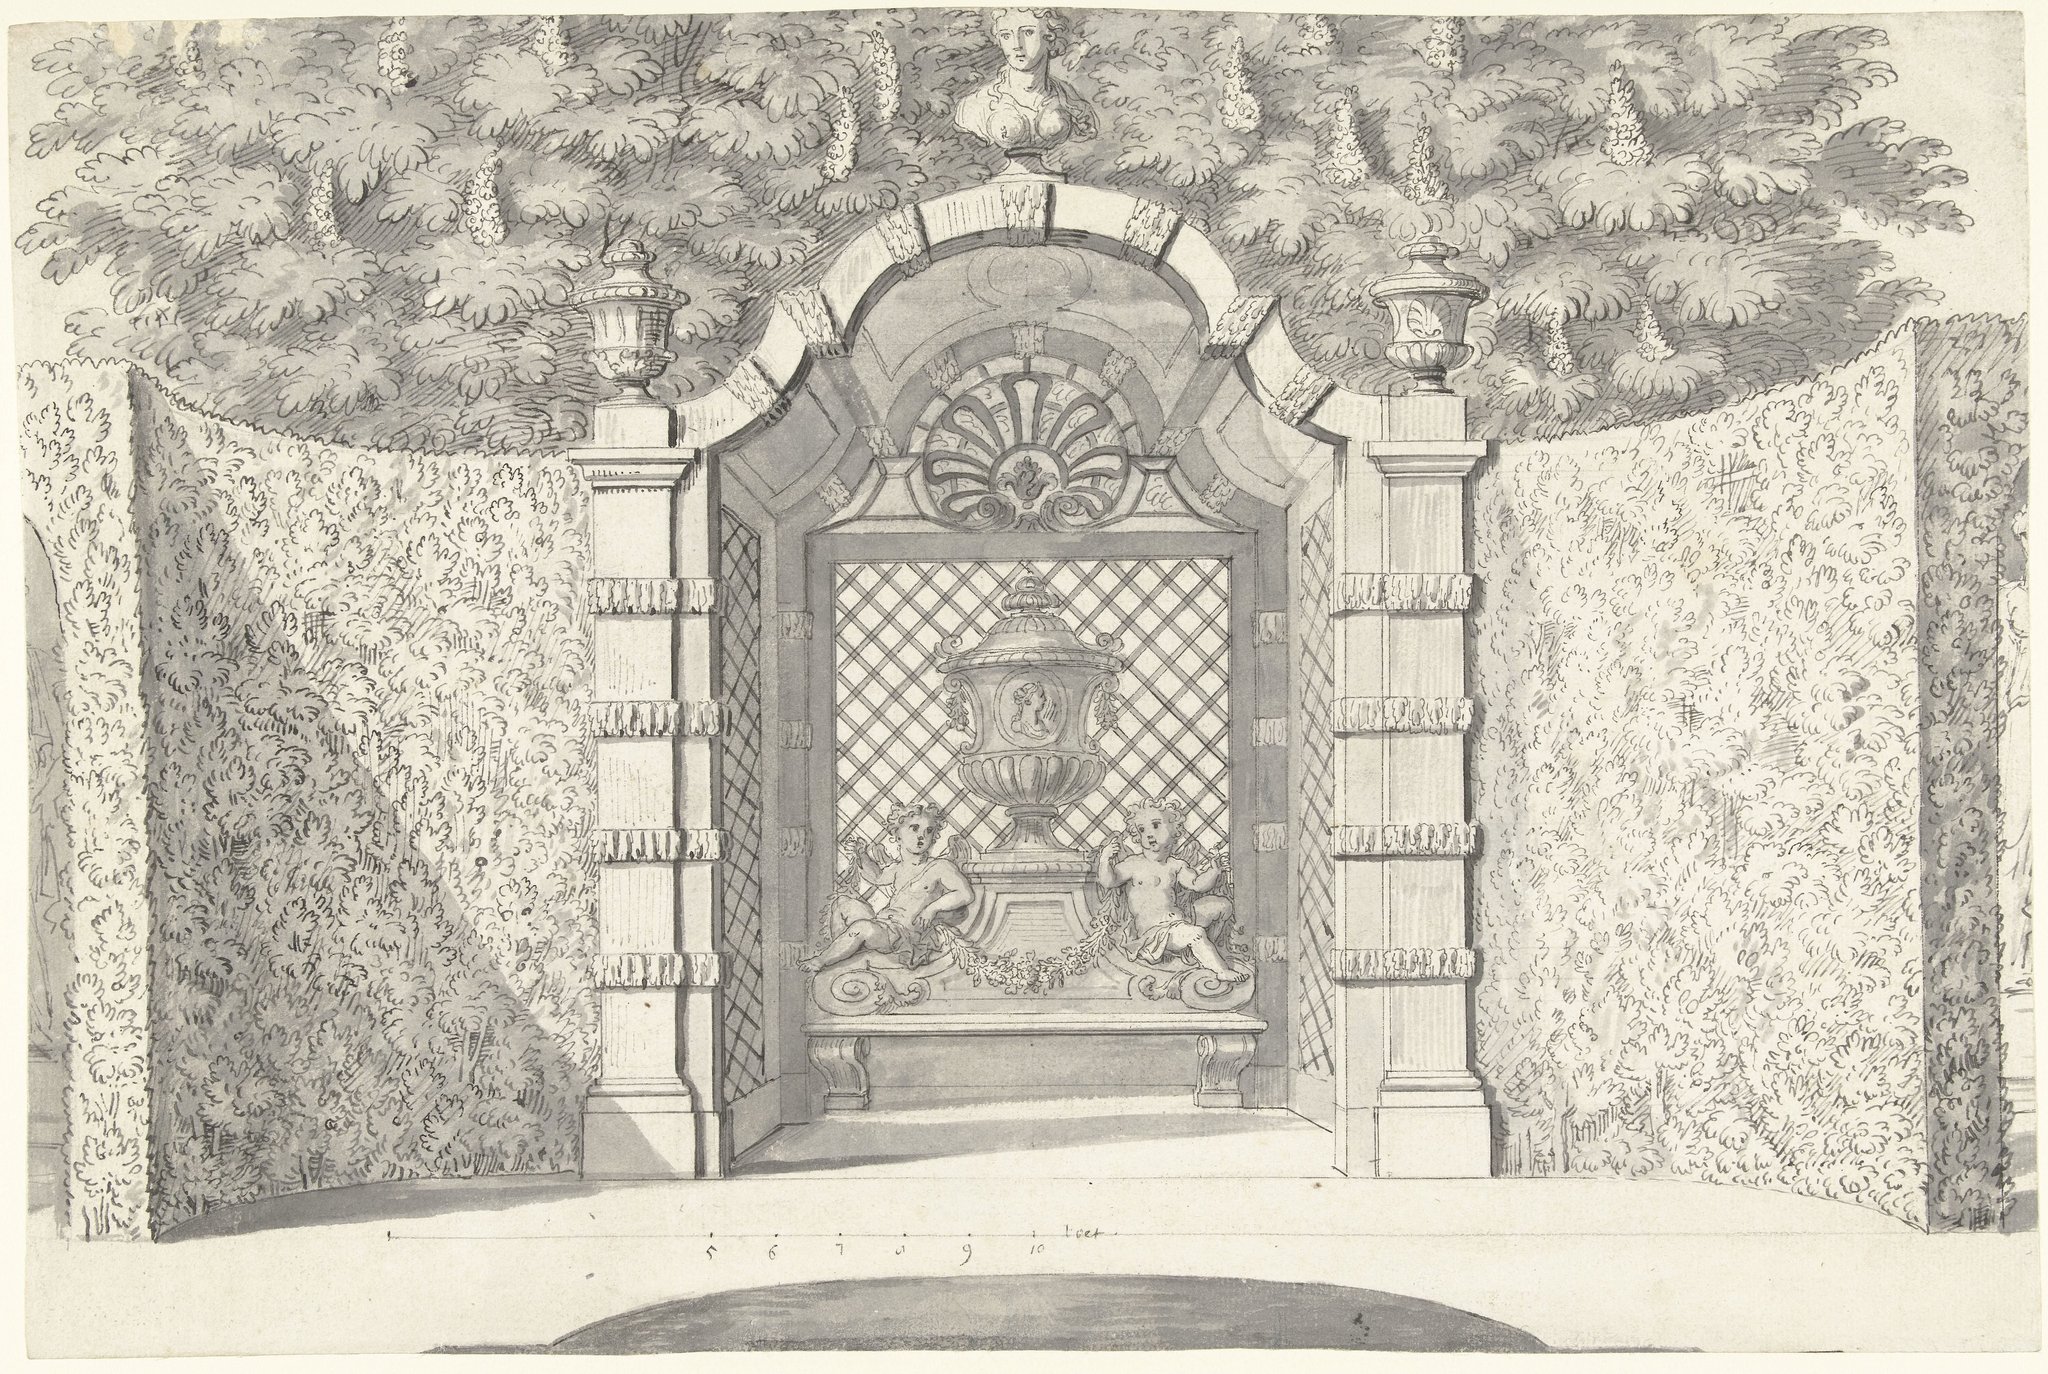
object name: drawing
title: Ontwerp voor een tuindecoratie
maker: daniël marot (ii)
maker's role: draughtsman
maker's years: 1695-1769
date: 1705-1769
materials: ink, paper, pencil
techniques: brush, pen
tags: garden vase